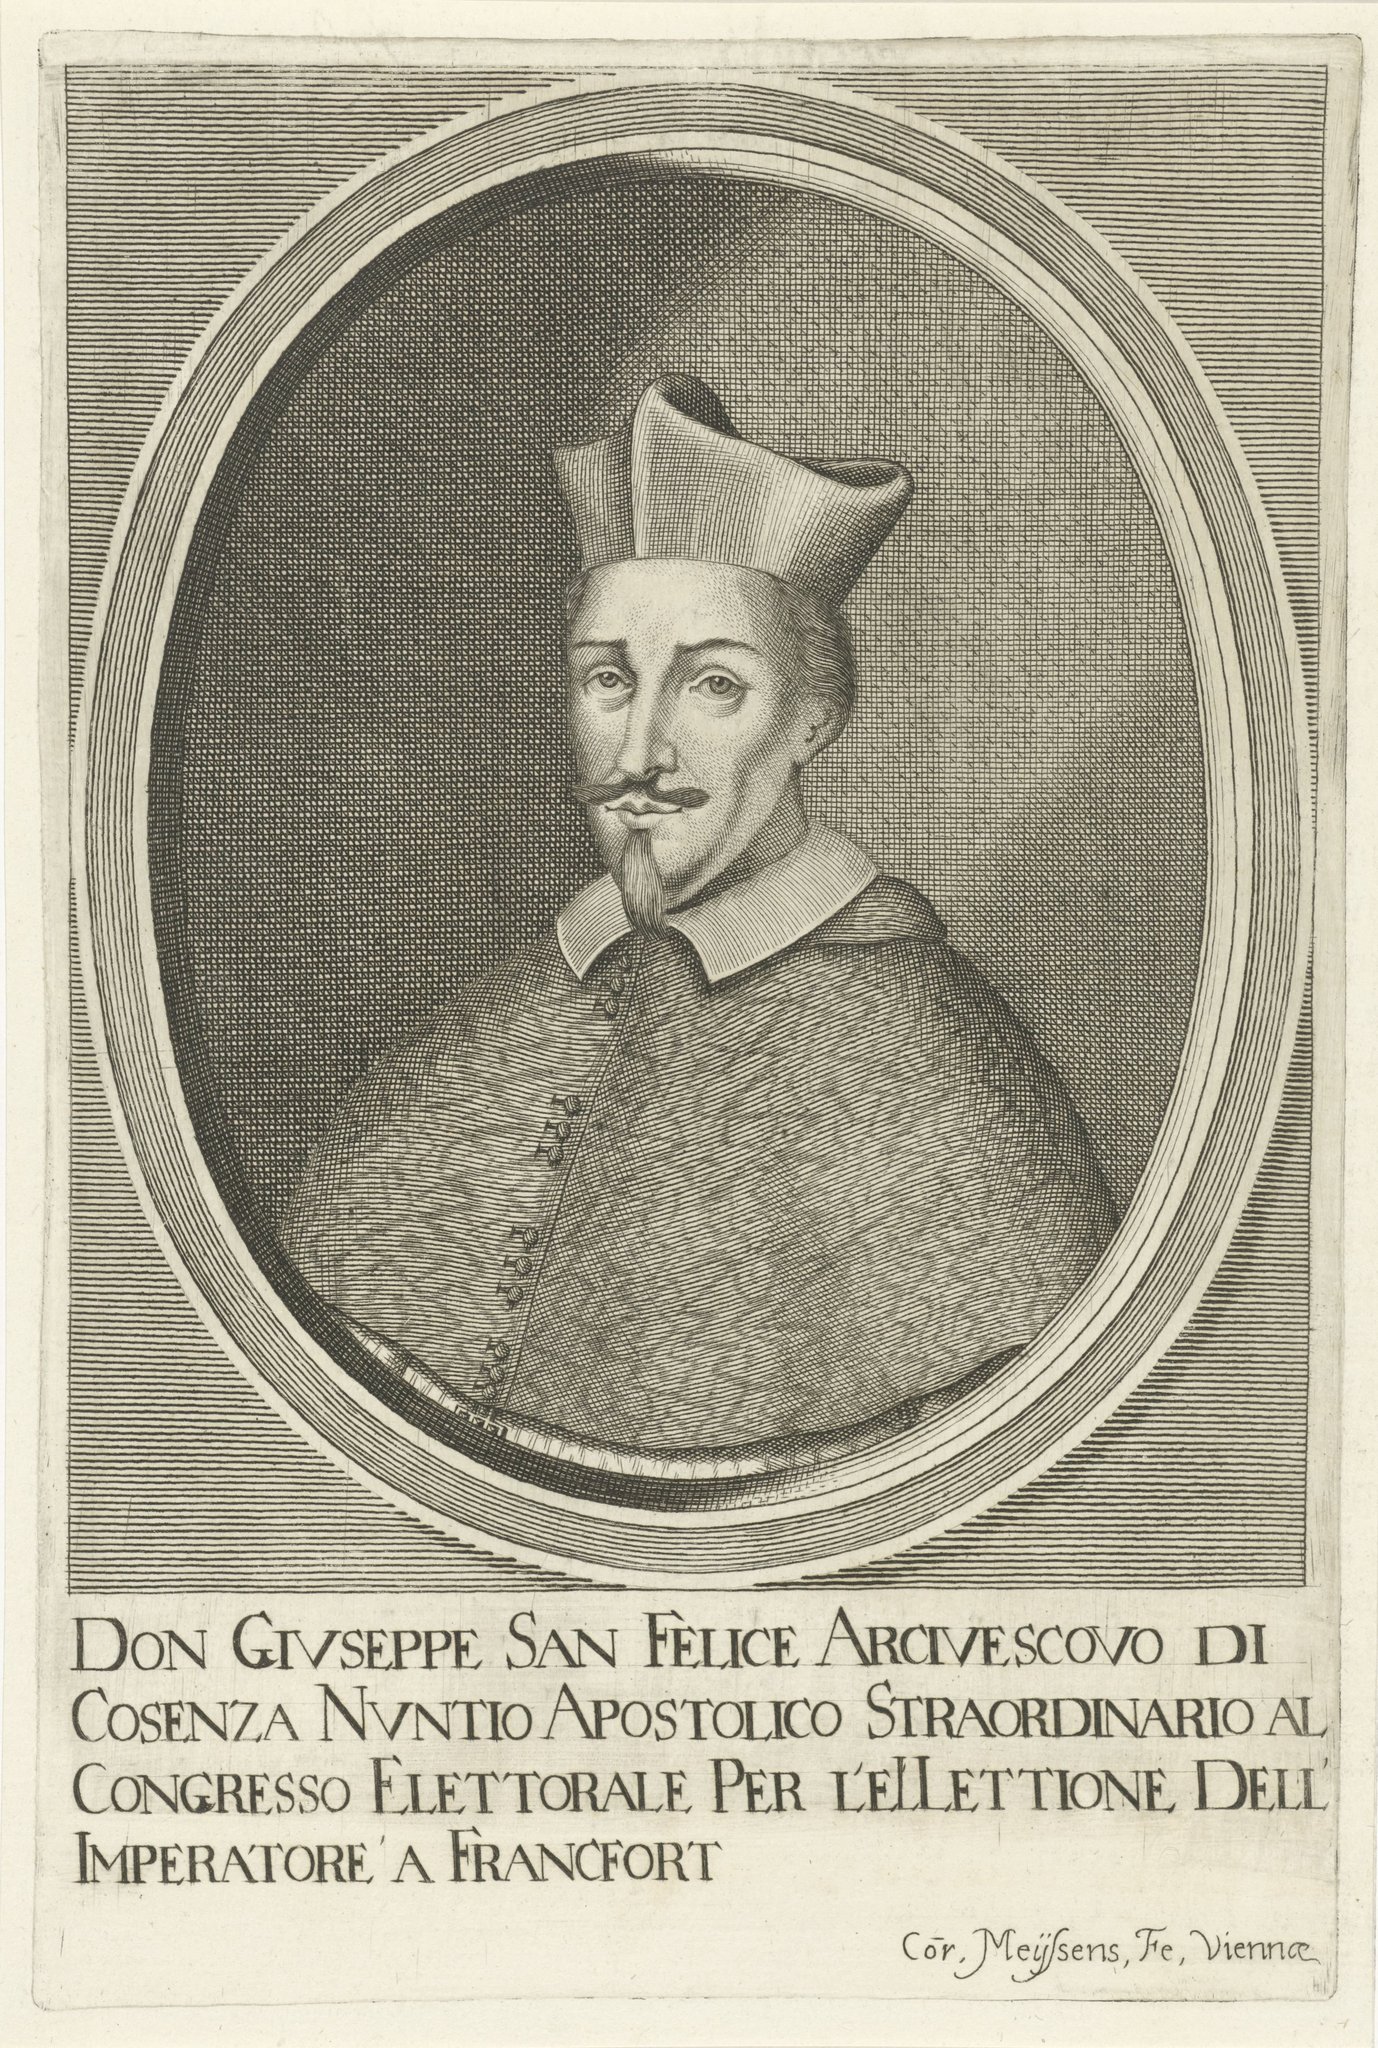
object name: print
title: Portret van Giuseppe Francisco Maria Sanfelice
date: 1670-1674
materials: paper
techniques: engraving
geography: vienna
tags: naples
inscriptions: inscription: ‘Drug 18022’, collector's mark: Lugt 2228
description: Prent mogelijk gebruikt in: Gualdo Priorato, Galeazzo. Historia di Leopoldo Cesare, (...). 3 dln. Wenen, Giovanni Battista Hacque, 1670-1674.